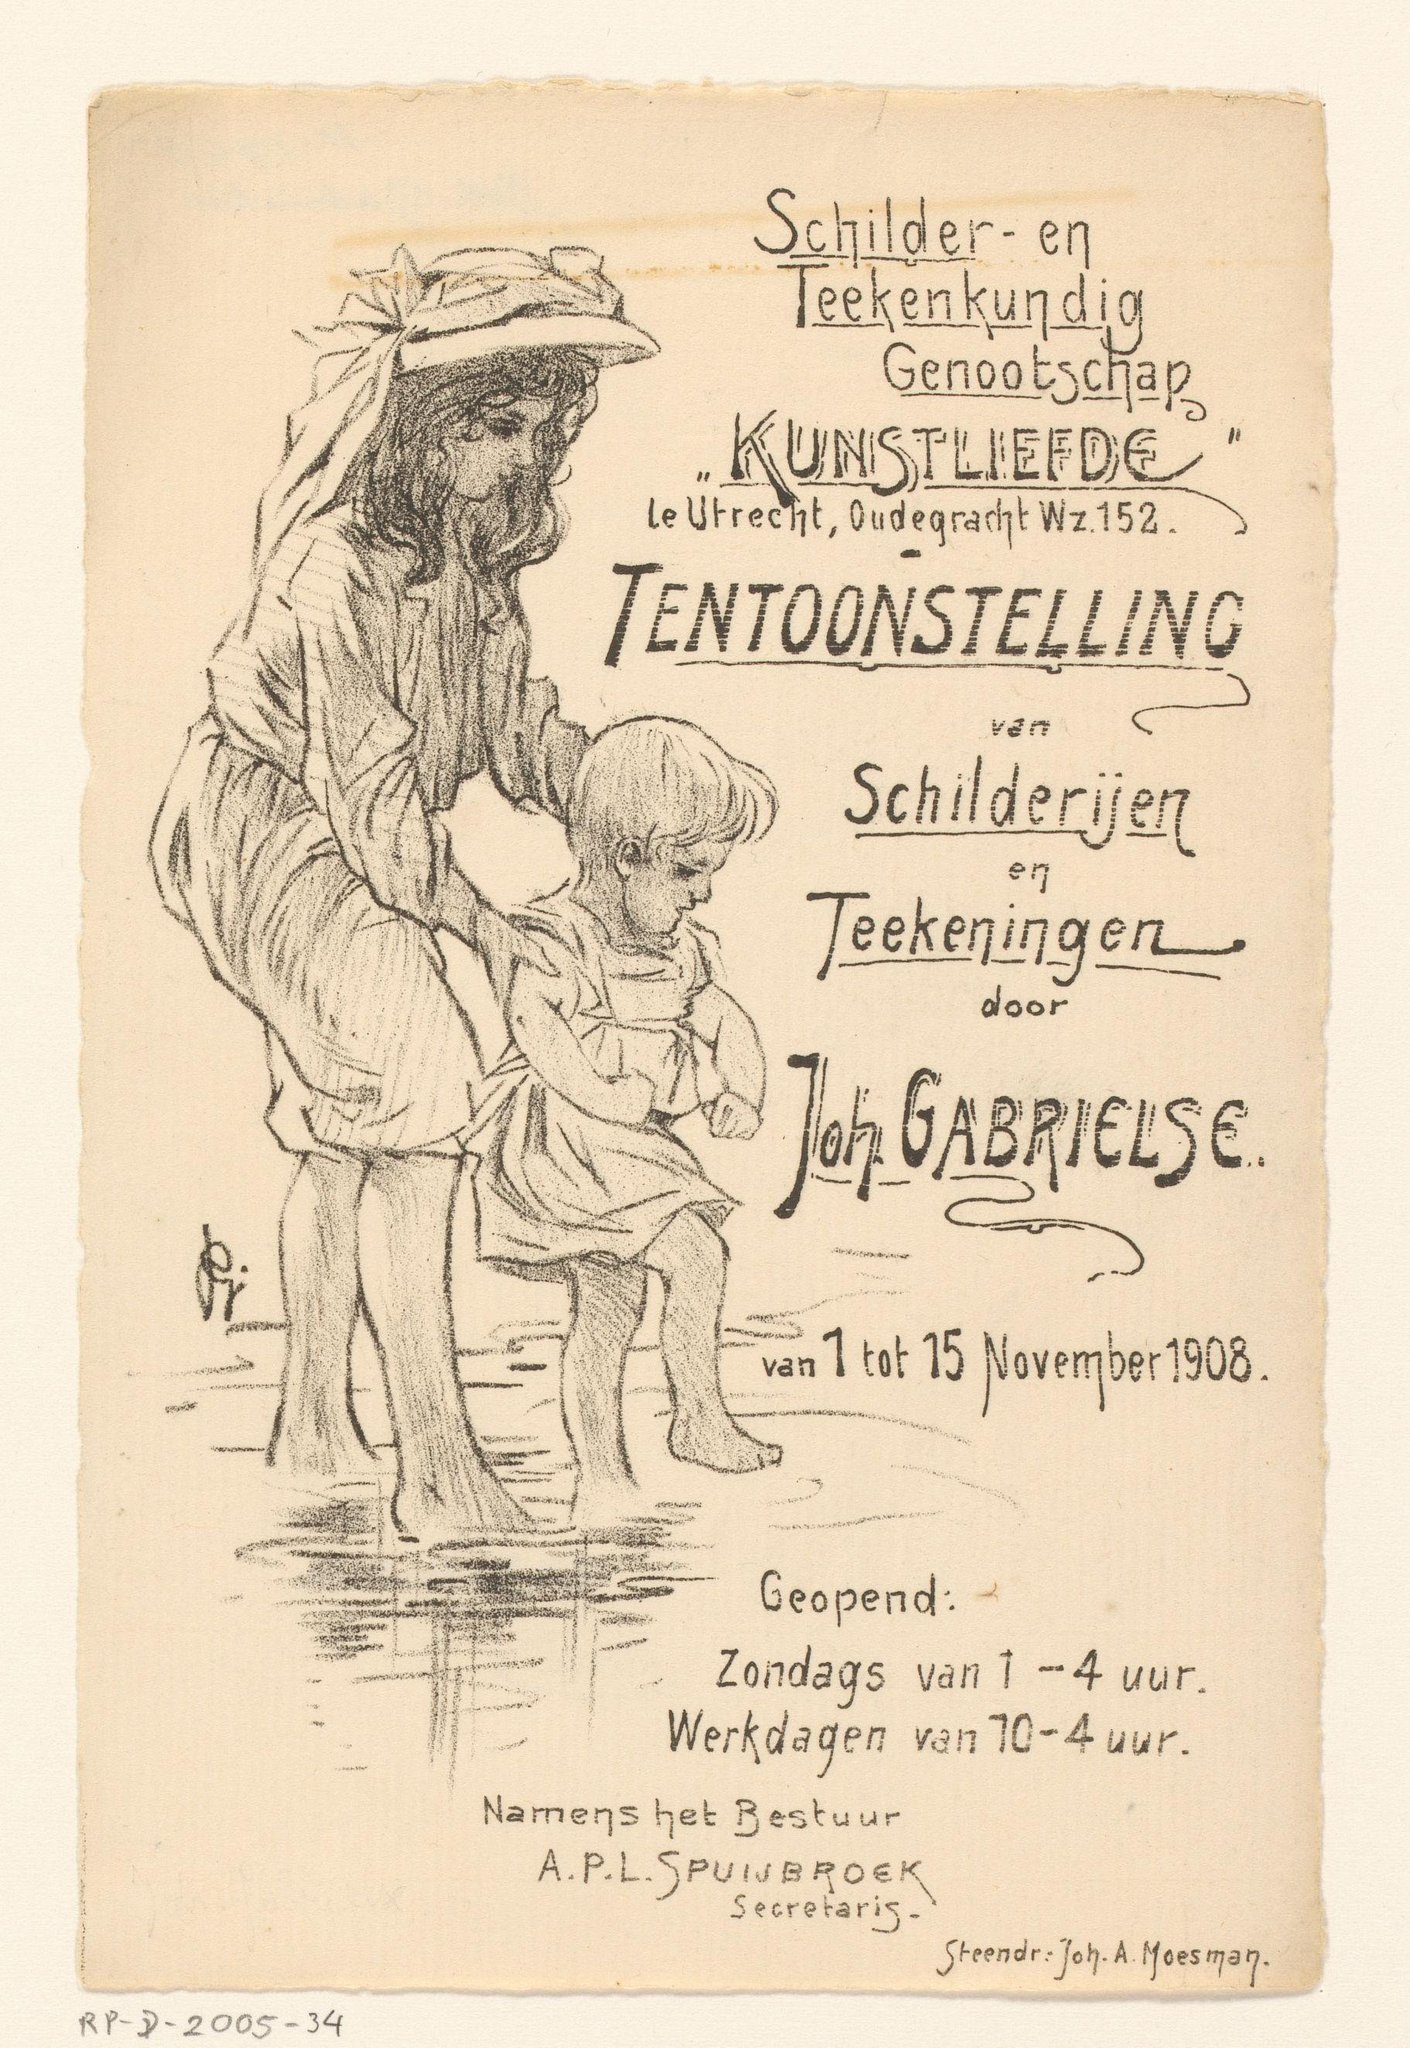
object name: print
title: Uitnodiging van Schilder- en Teekenkundig Genootschap "Kunstliefde" voor een tentoonstelling van het werk van Johan Gabriëlse, 1-15 november 1908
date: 1908-1911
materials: paper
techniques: lithograph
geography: utrecht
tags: painter, johan gabriëlse, criticizing and discussing art, art criticism, circle, club of artists, collecting and exhibiting products of the fine arts, in or beside the water (on the beach)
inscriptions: collector's mark: Lugt 2228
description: Meisje en kind op het strand. Uitnodiging van Schilder- en Teekenkundig Genootschap "Kunstliefde" voor een tentoonstelling van schilderijen en tekeningen van Johan Gabriëlse, 1-15 november 1908.